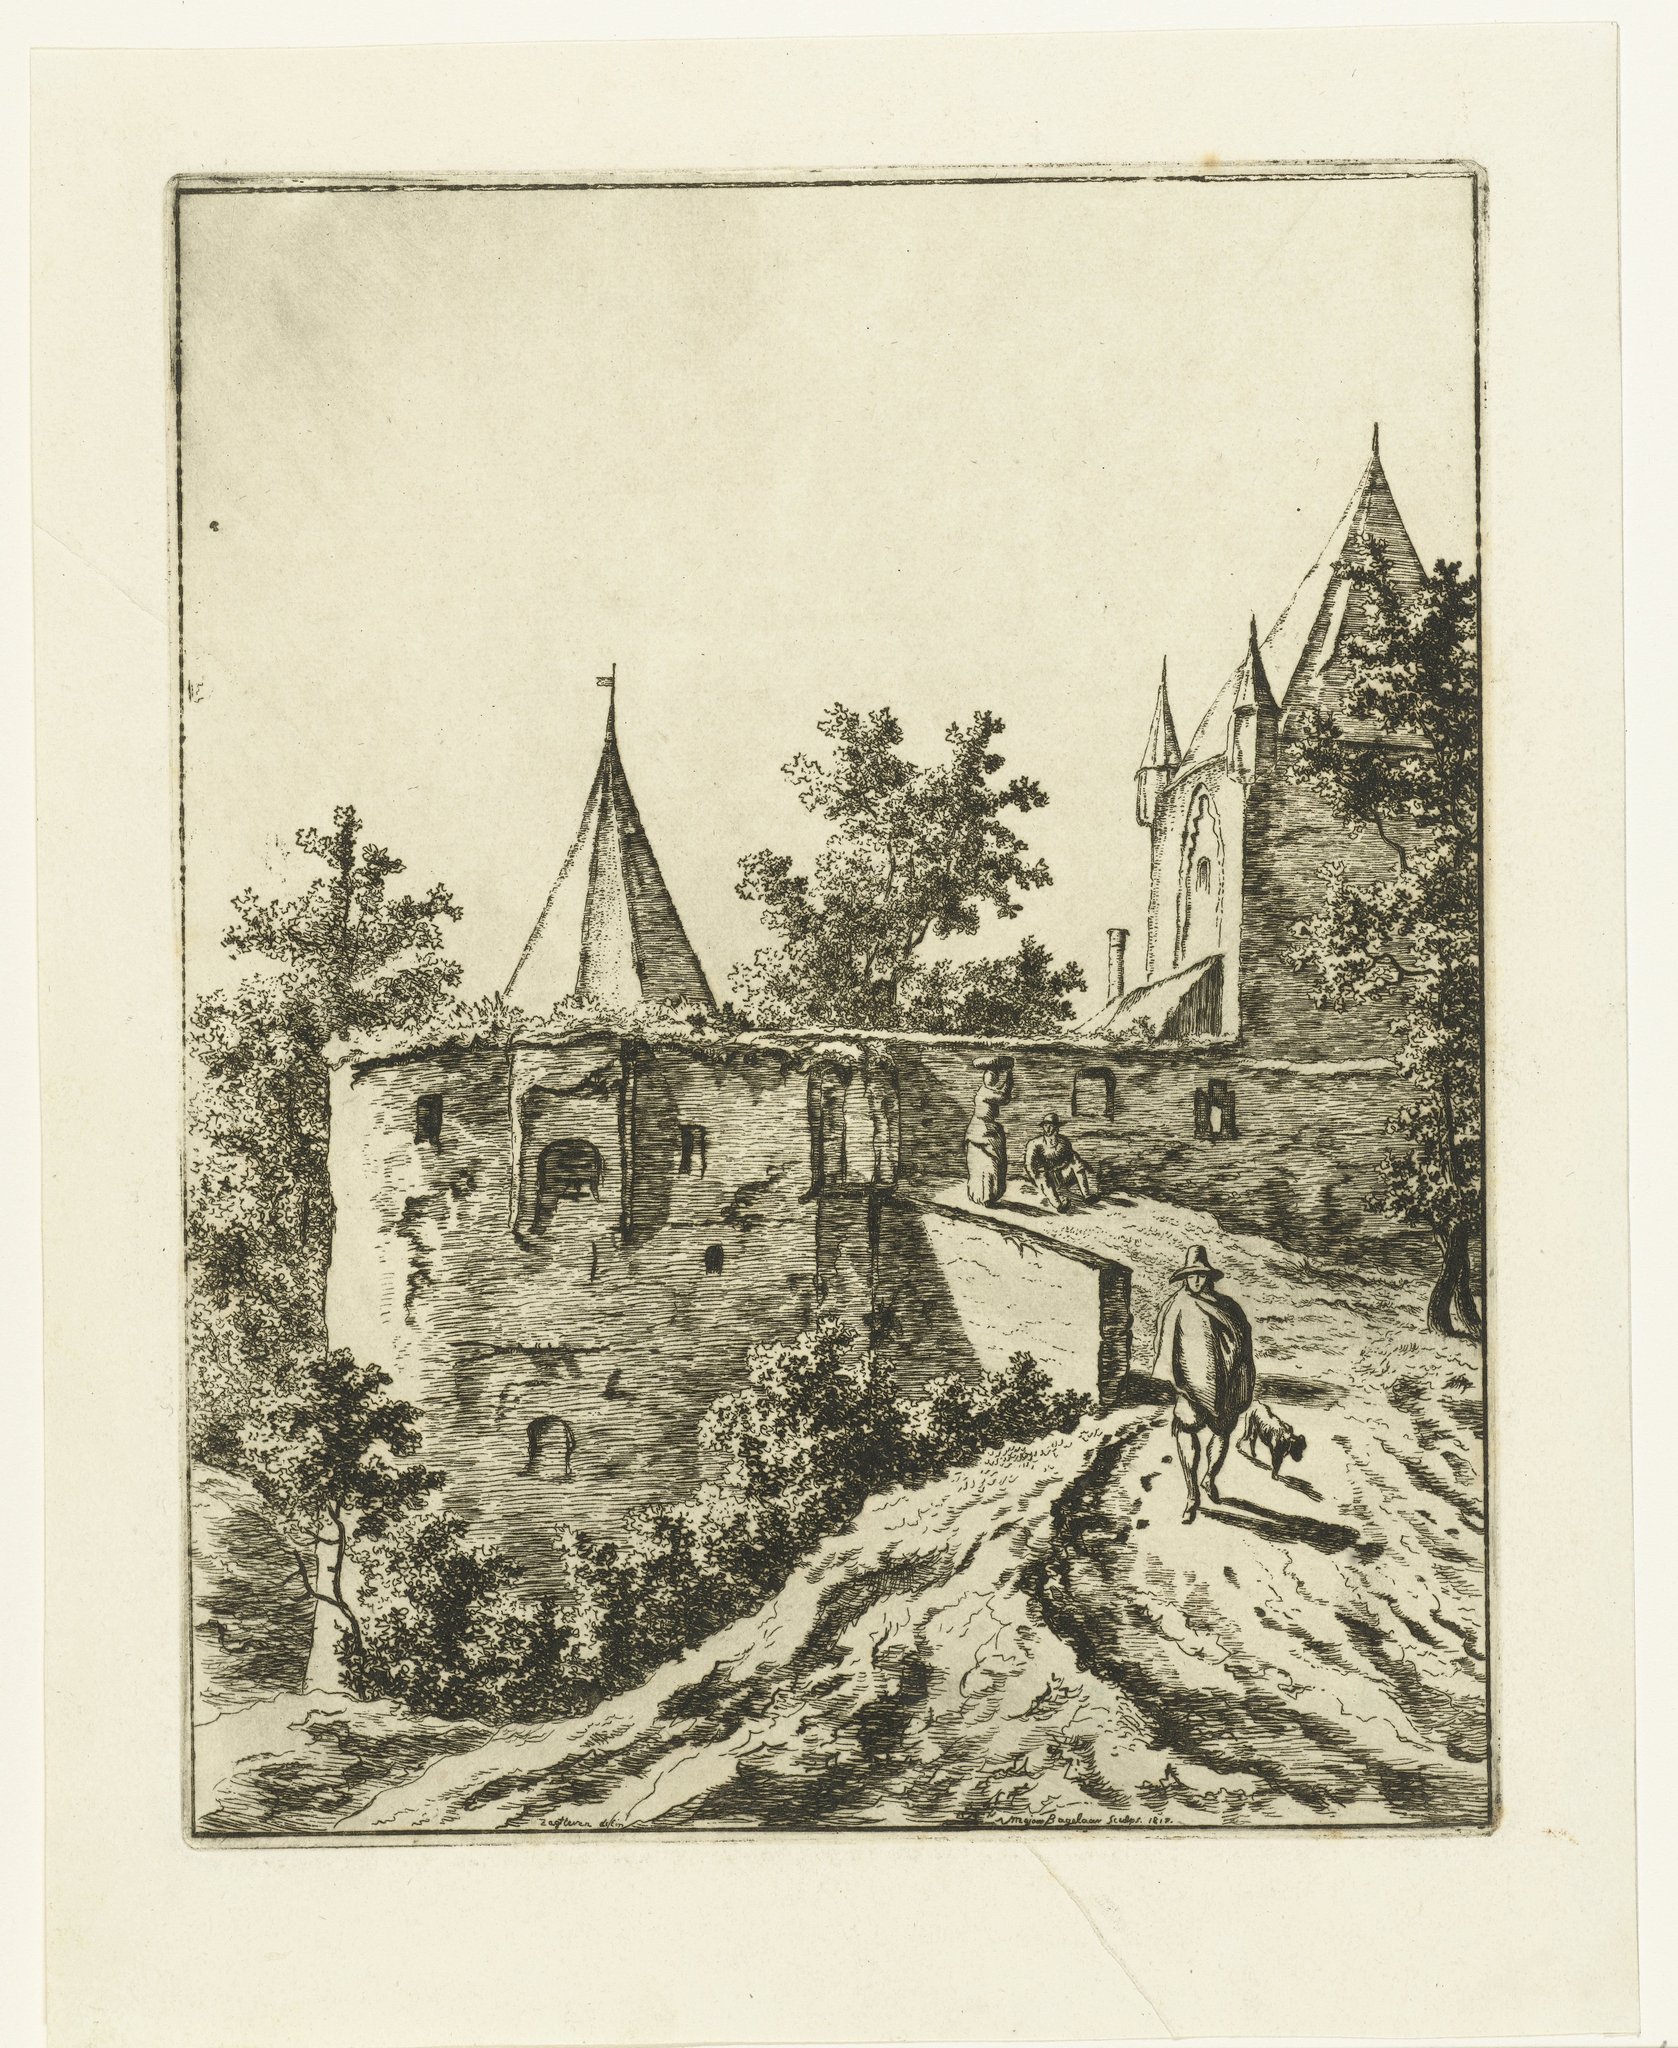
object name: print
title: De toegangsweg van het kasteel Saive bij Luik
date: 1818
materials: paper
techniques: etching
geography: netherlands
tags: castle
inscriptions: collector's mark: Lugt 2228